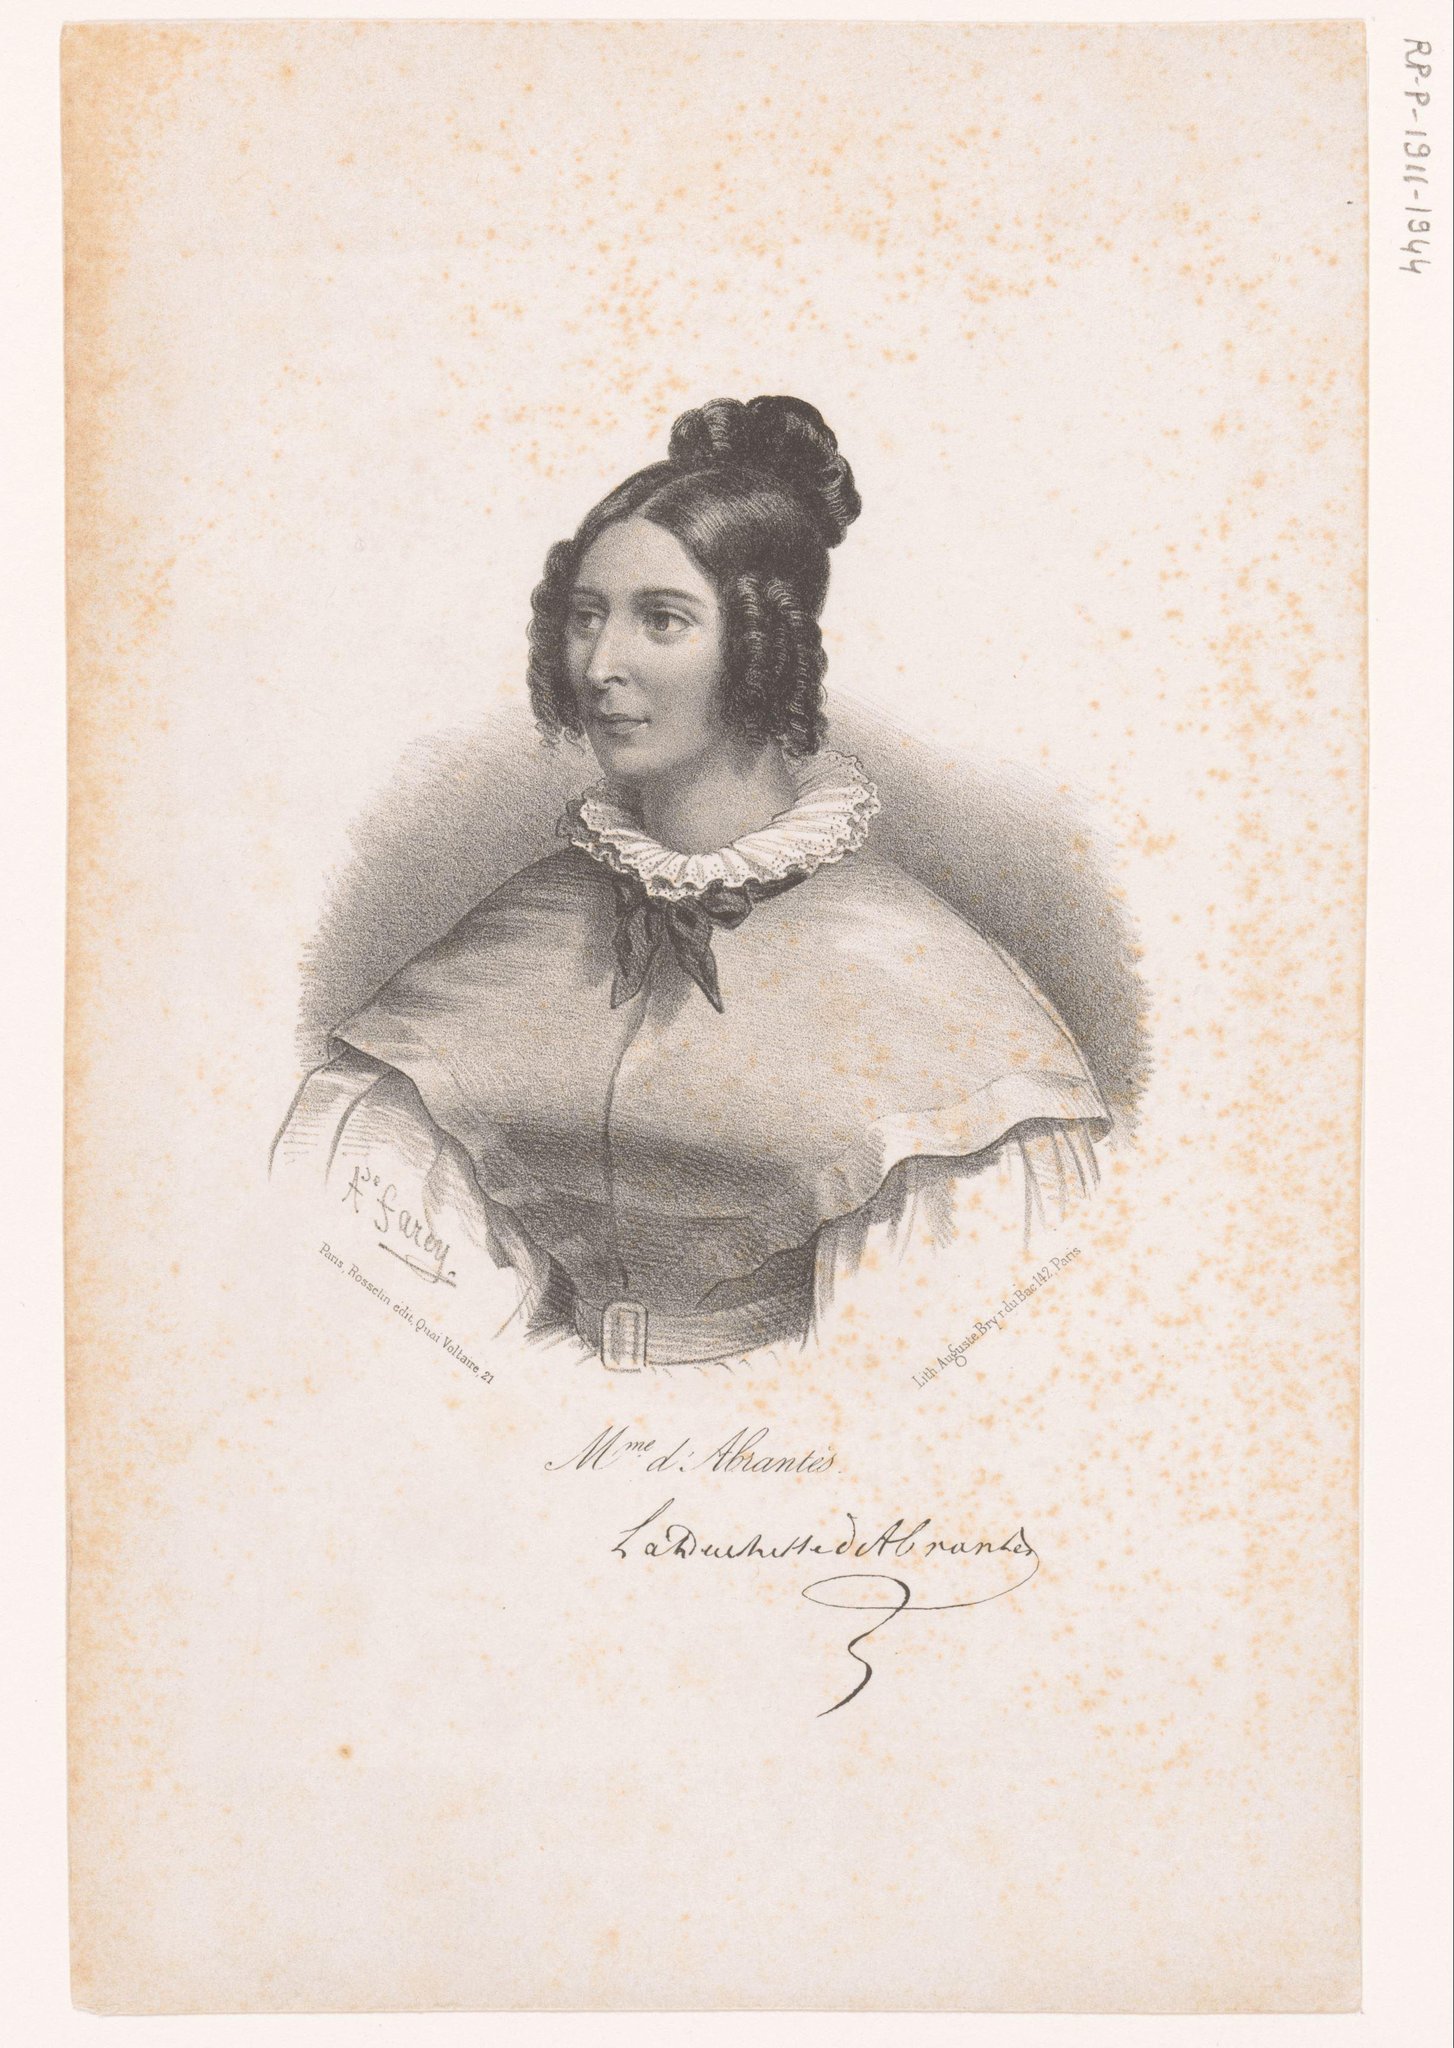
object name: print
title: Portret van Laure Junot d'Abrantès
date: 1848-1853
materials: paper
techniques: lithograph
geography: paris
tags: paris, historical persons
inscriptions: collector's mark: Lugt 2228a